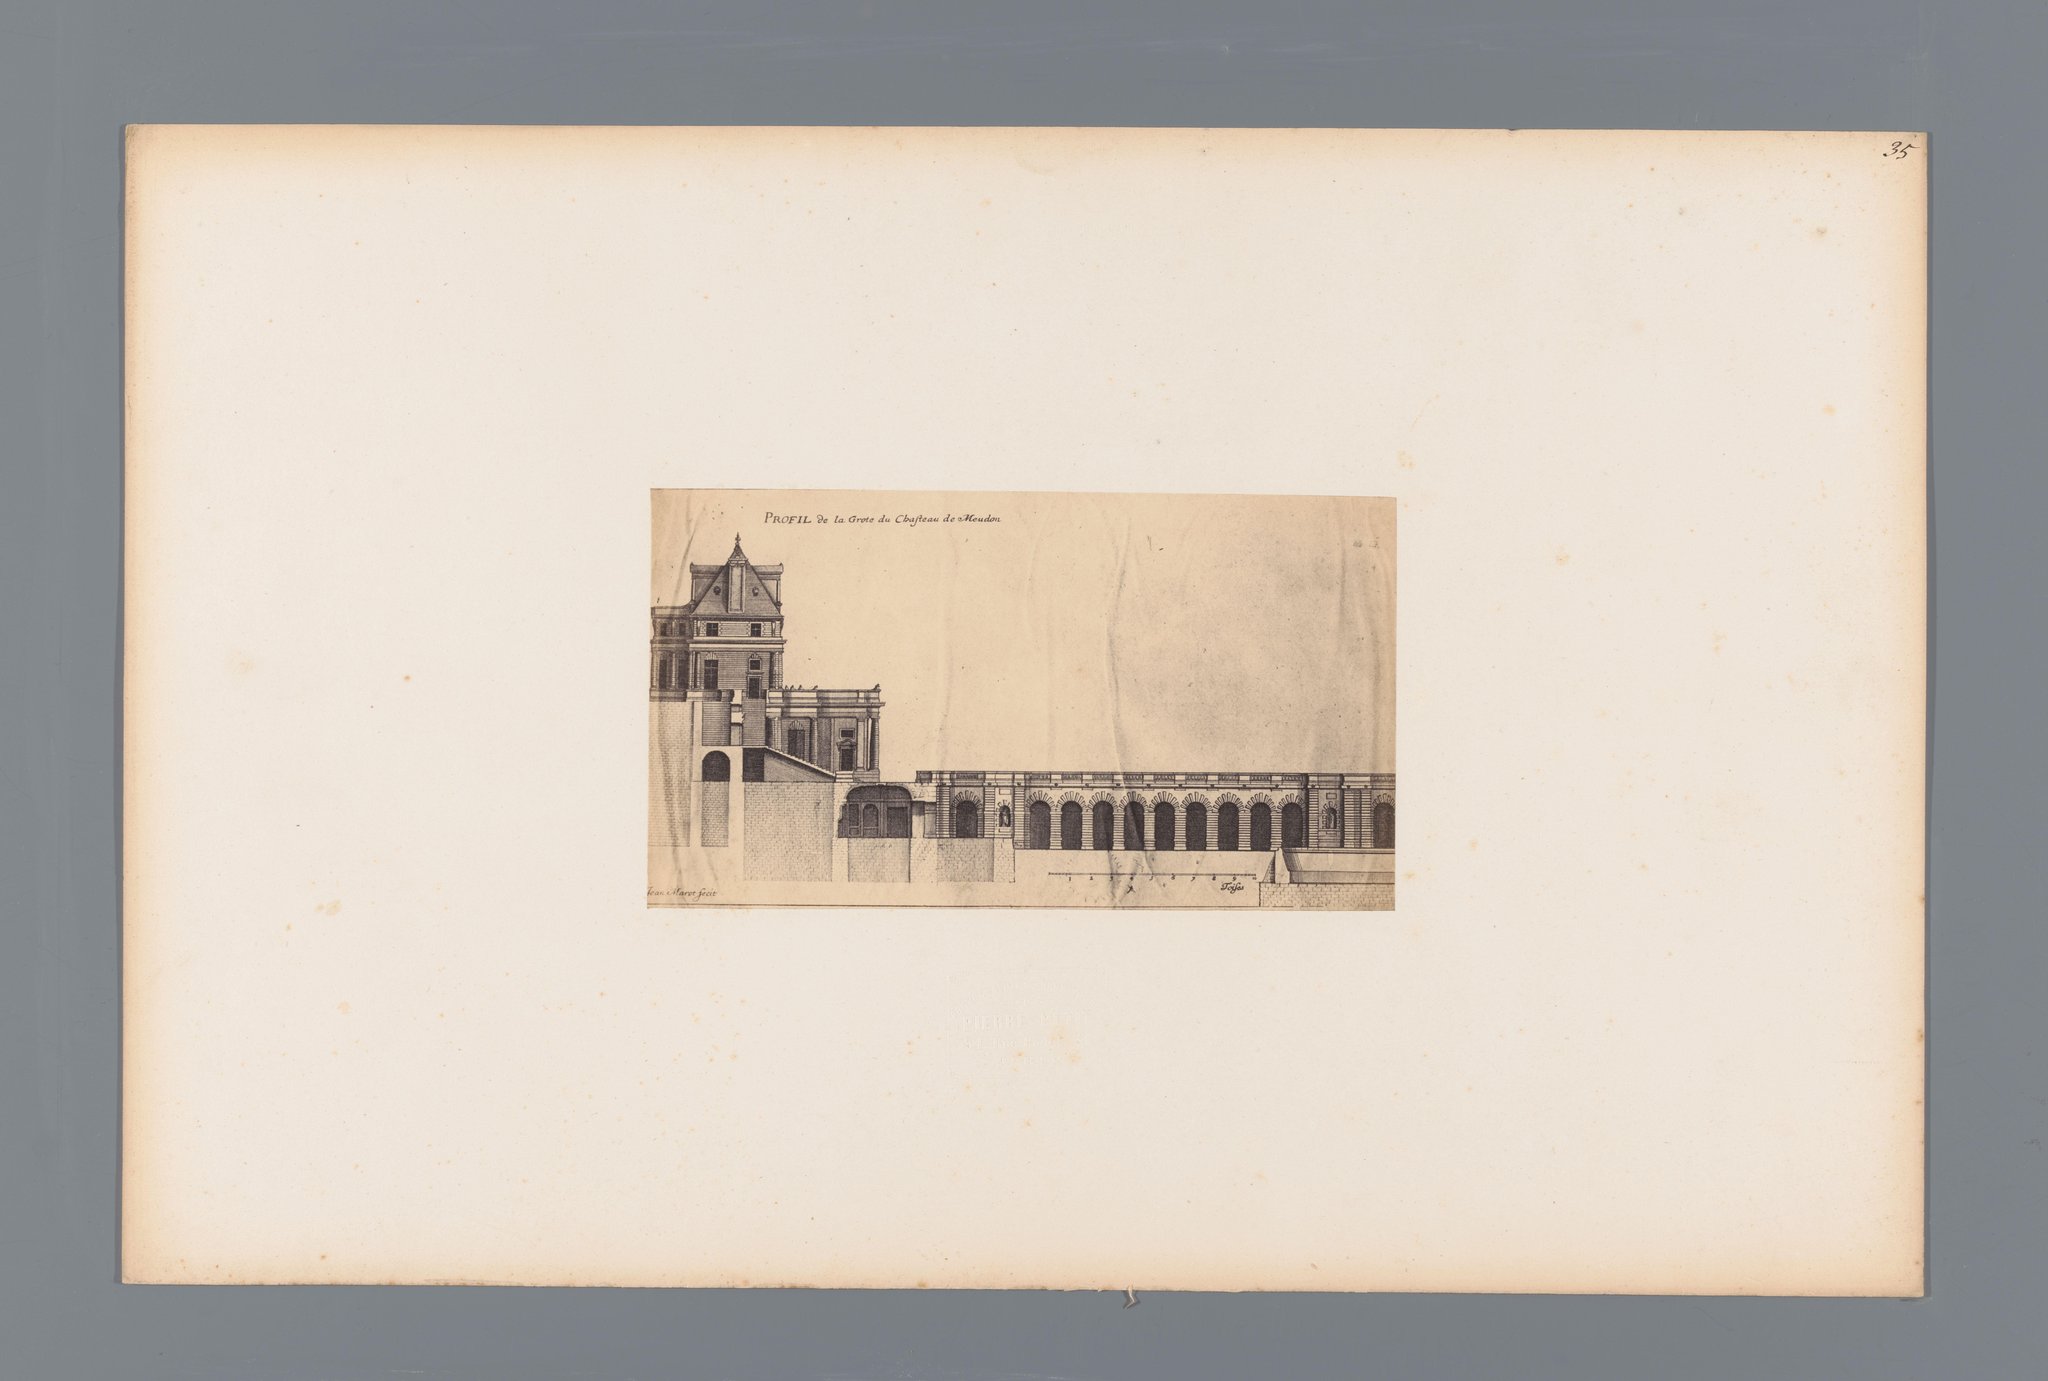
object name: reproduction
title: Fotoreproductie van een ontwerp van de grot van het kasteel van Meudon door Jean Marot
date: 1860-1865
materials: photographic support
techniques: albumen print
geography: paris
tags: castle, cave, grotto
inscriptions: check stamp: ‘PHOTOGRAPHIE des DEUX MONDES/ PIERRE PETIT/ 31, Rue Cadet, 31/ PARIS’, number: ‘35’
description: Deze foto maakt deel uit van een omslag met 38 foto's en 17 tekstbladen.